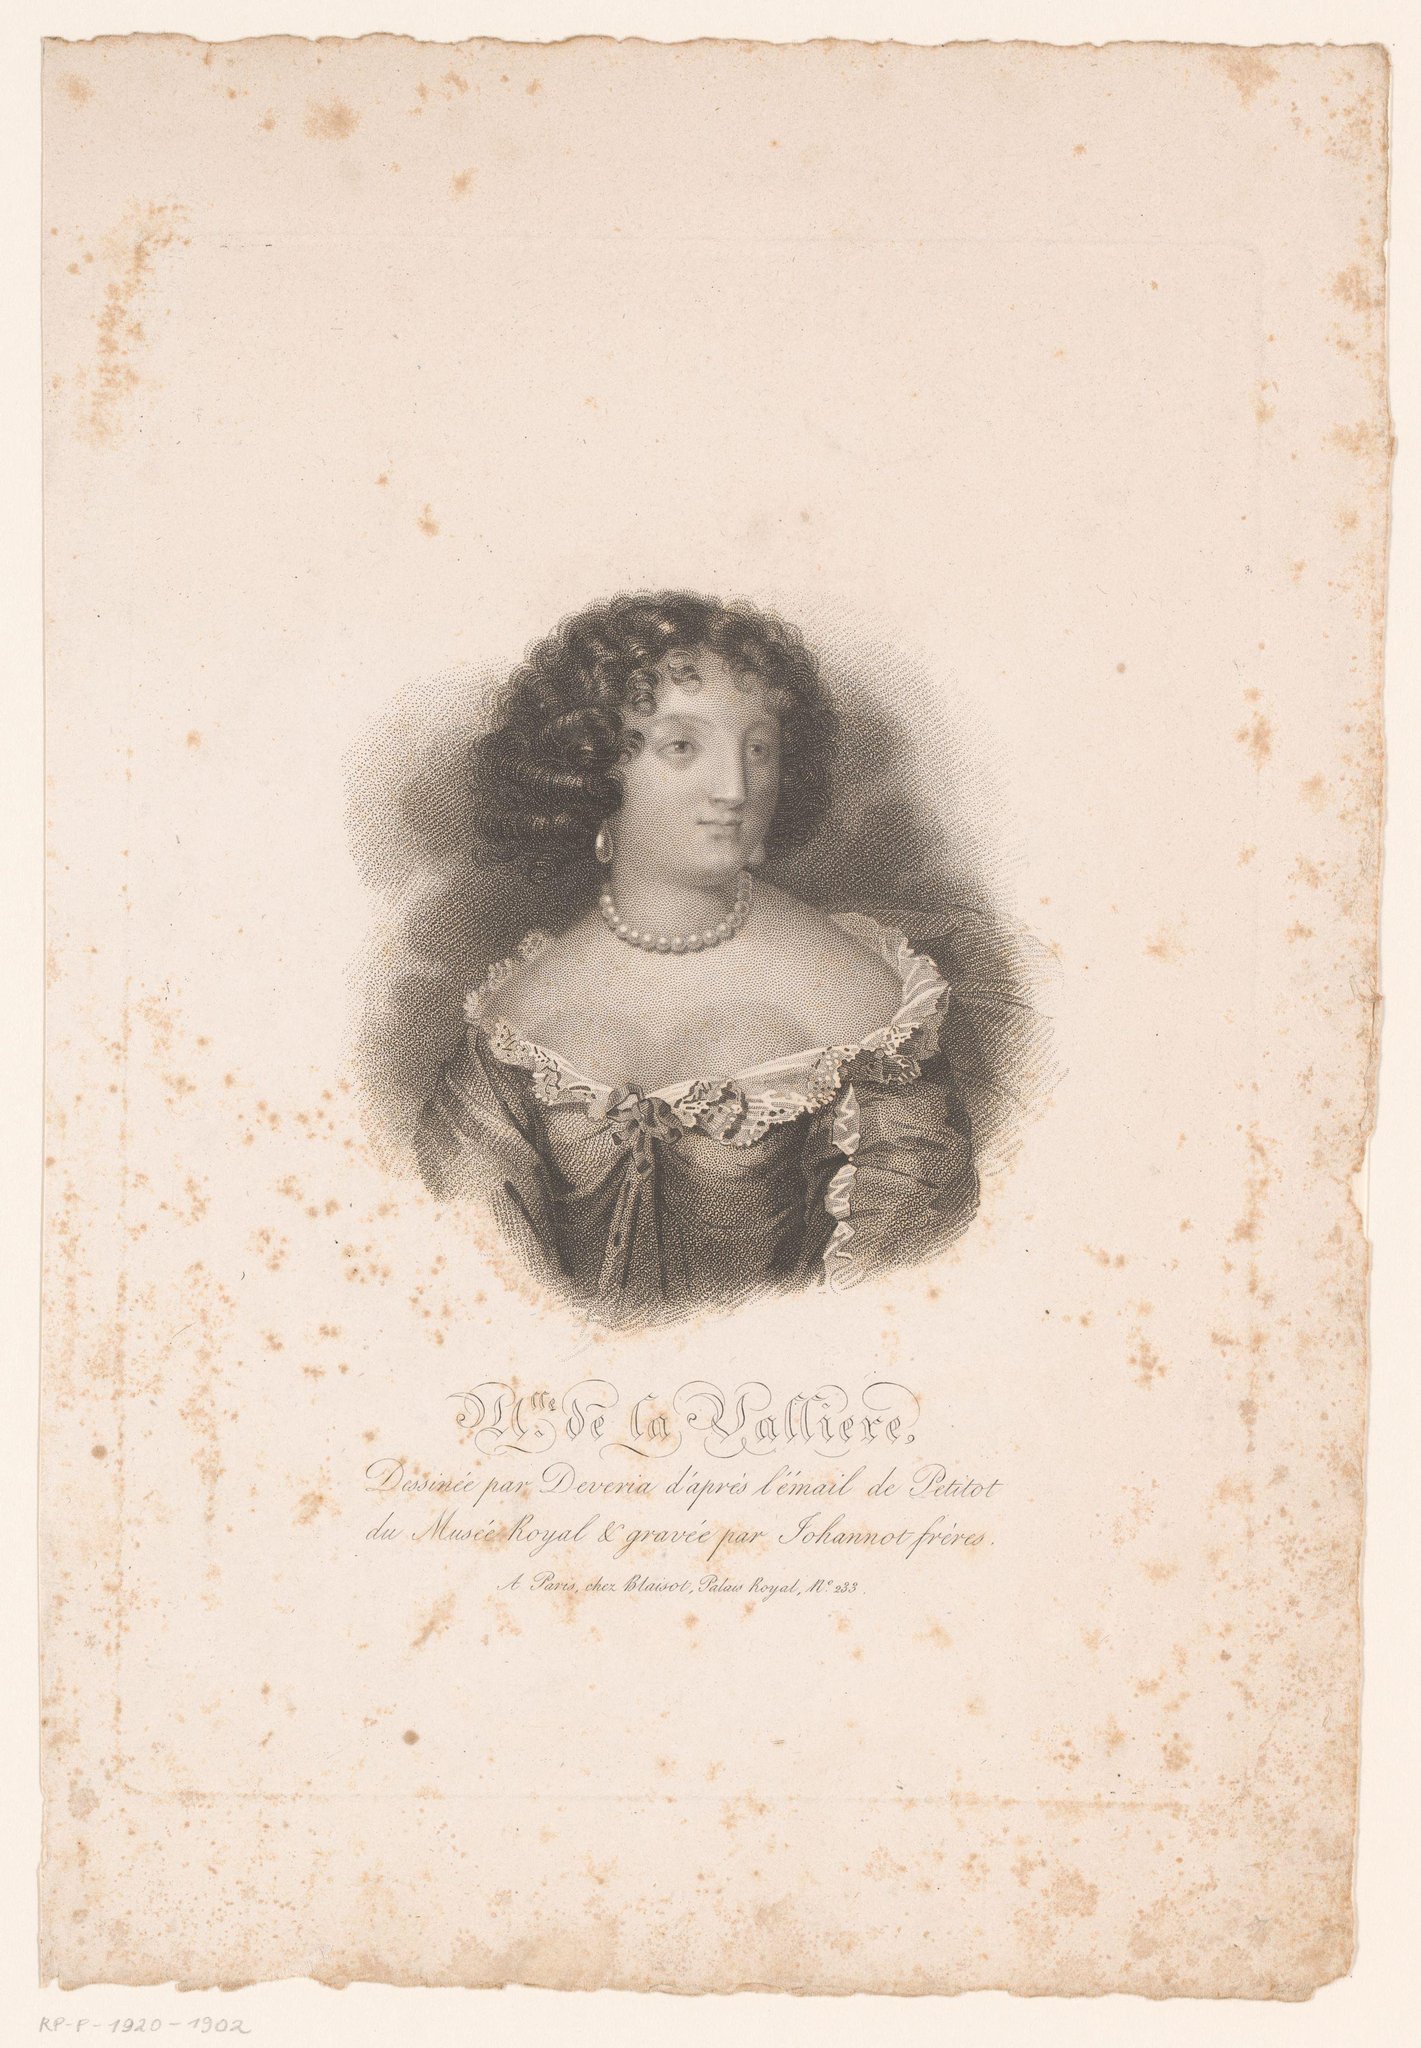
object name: print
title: M.lle de la Valliere.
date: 1829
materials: paper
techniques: etching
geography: paris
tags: paris, historical persons - bb - woman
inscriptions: collector's mark: Lugt 2228